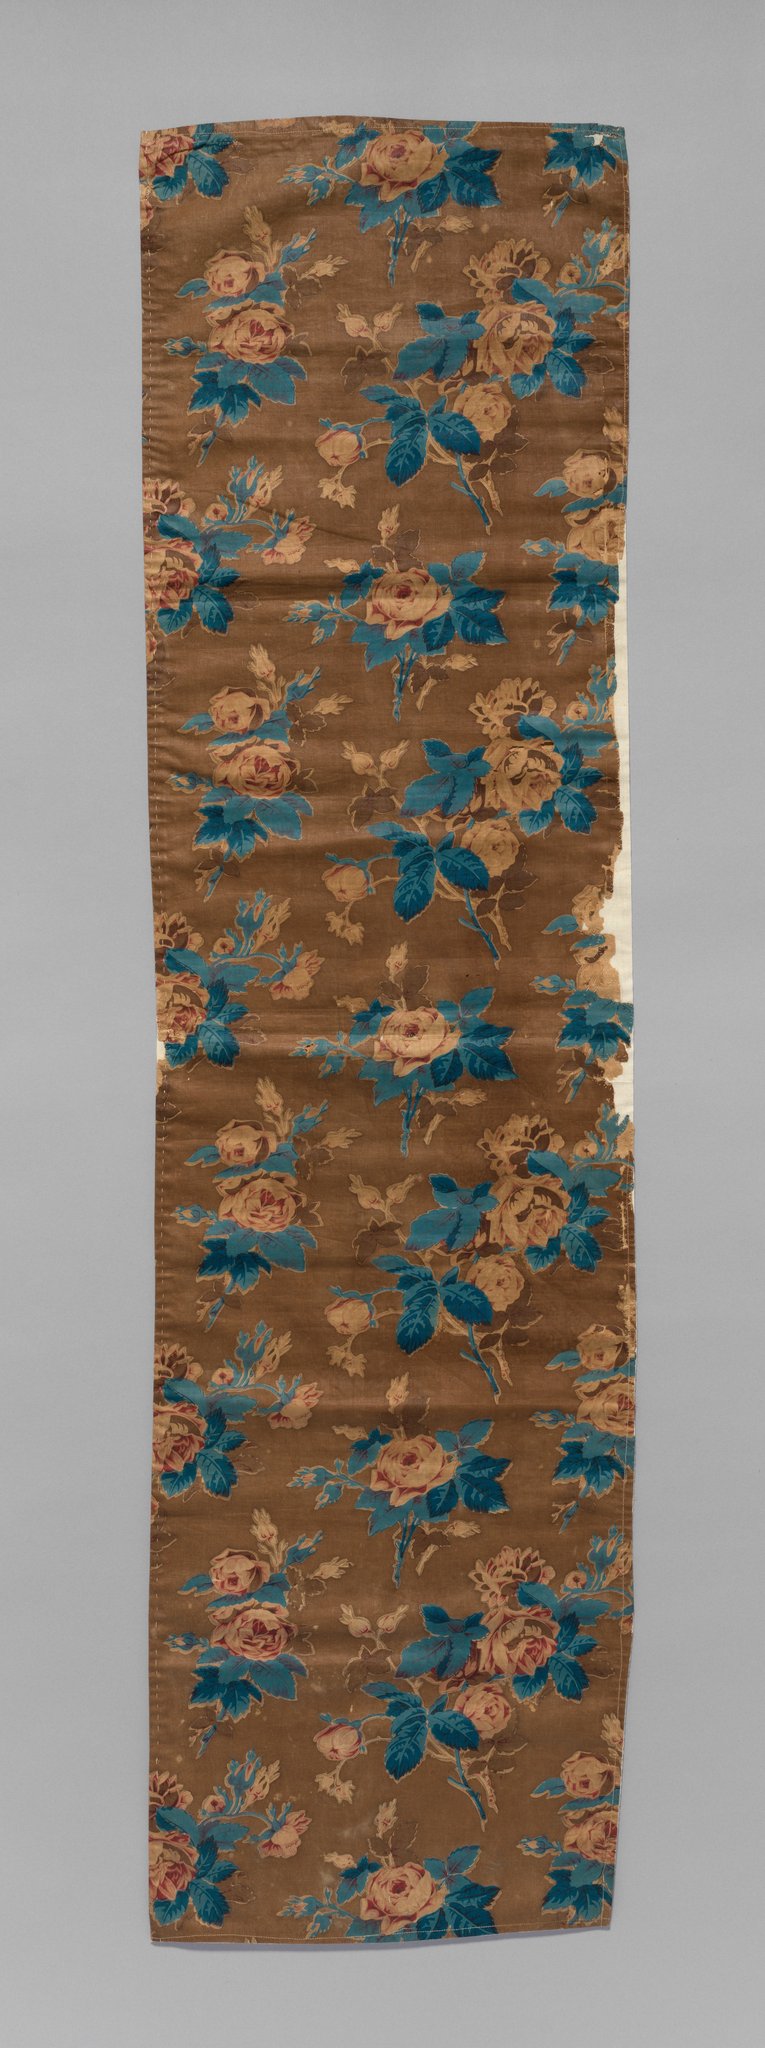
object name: piece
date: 1837-1851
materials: cotton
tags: roses